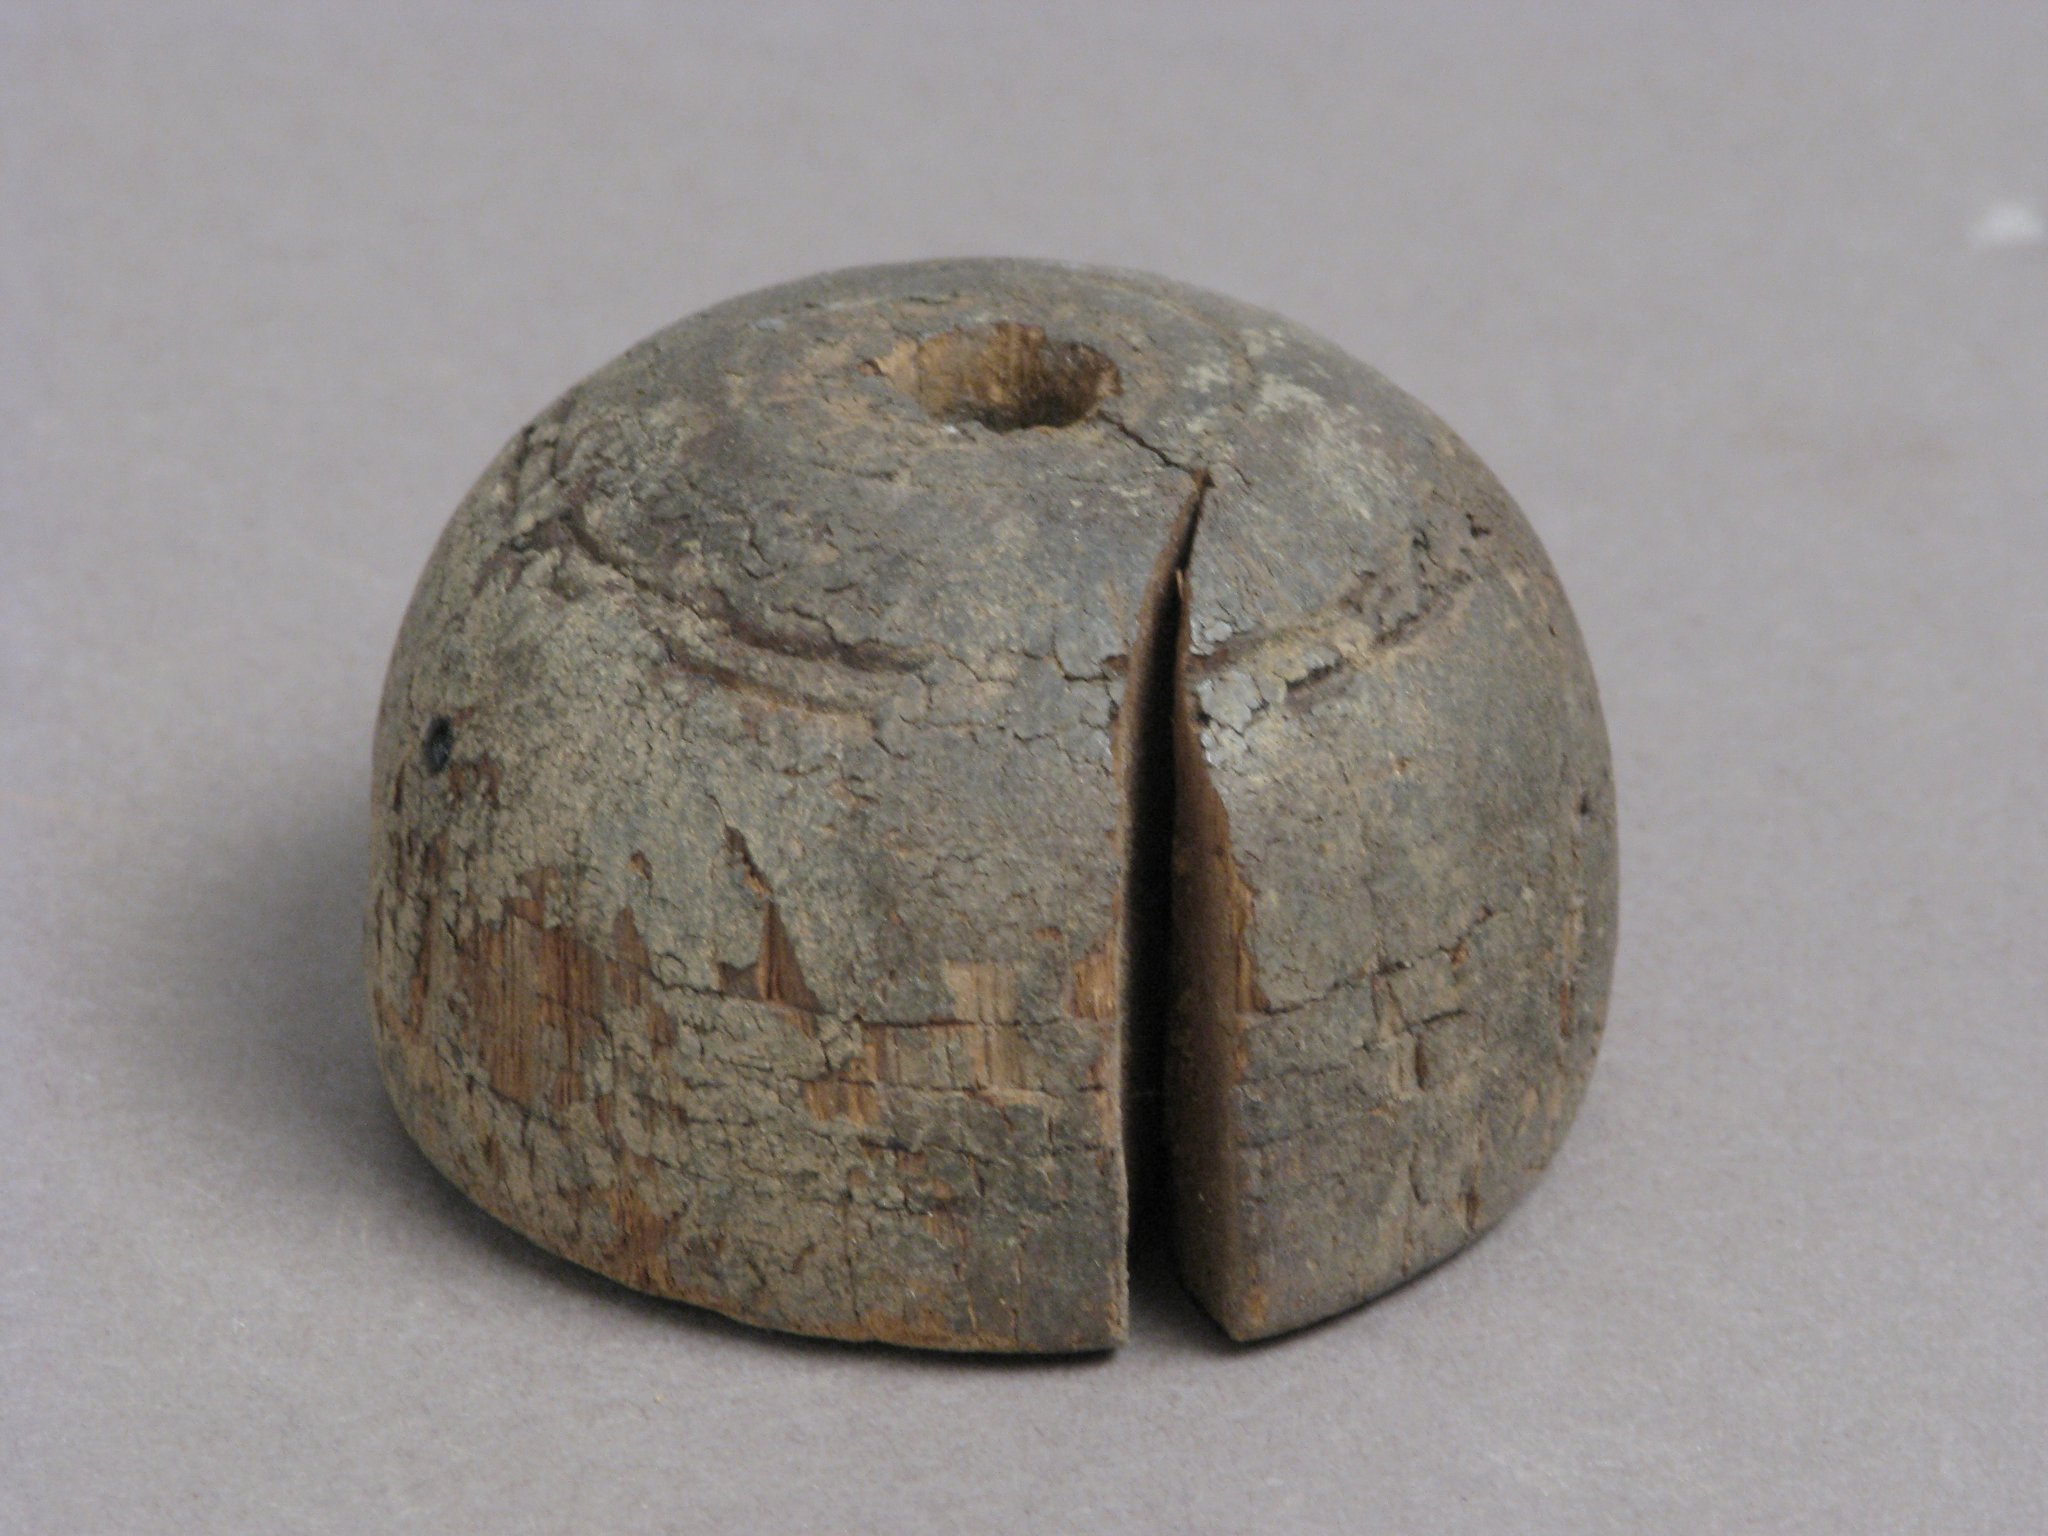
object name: whorl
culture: coptic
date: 301-700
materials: wood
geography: egypt